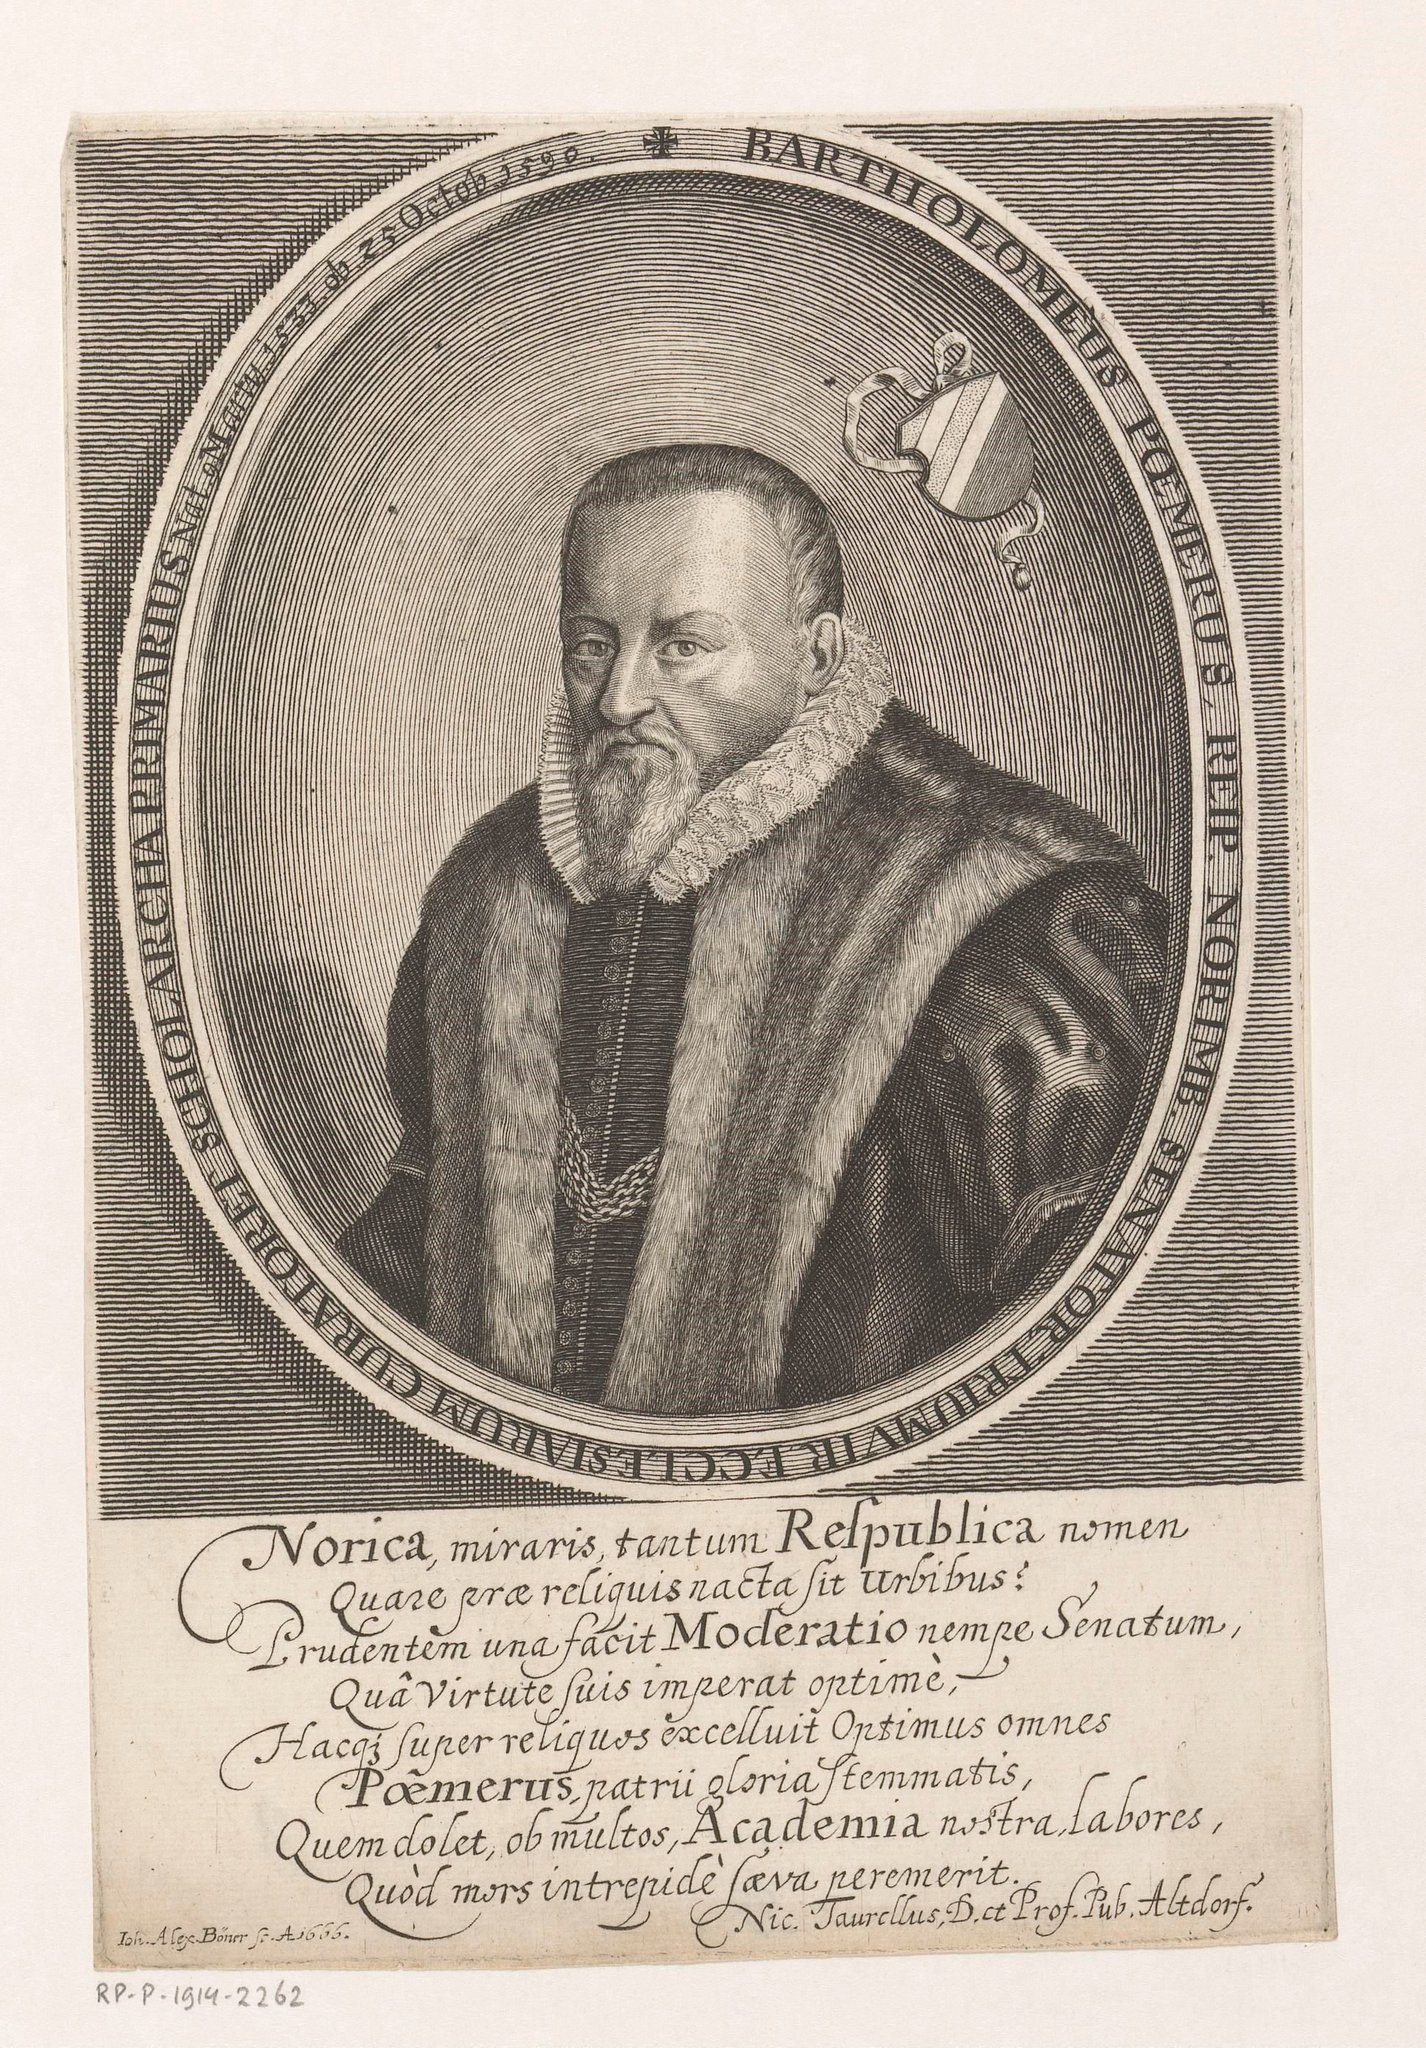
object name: print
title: Portret van Bartholomäus Pömer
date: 1666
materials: paper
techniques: engraving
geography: altdorf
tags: historical persons, armorial bearing, heraldry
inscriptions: collector's mark: Lugt 2228